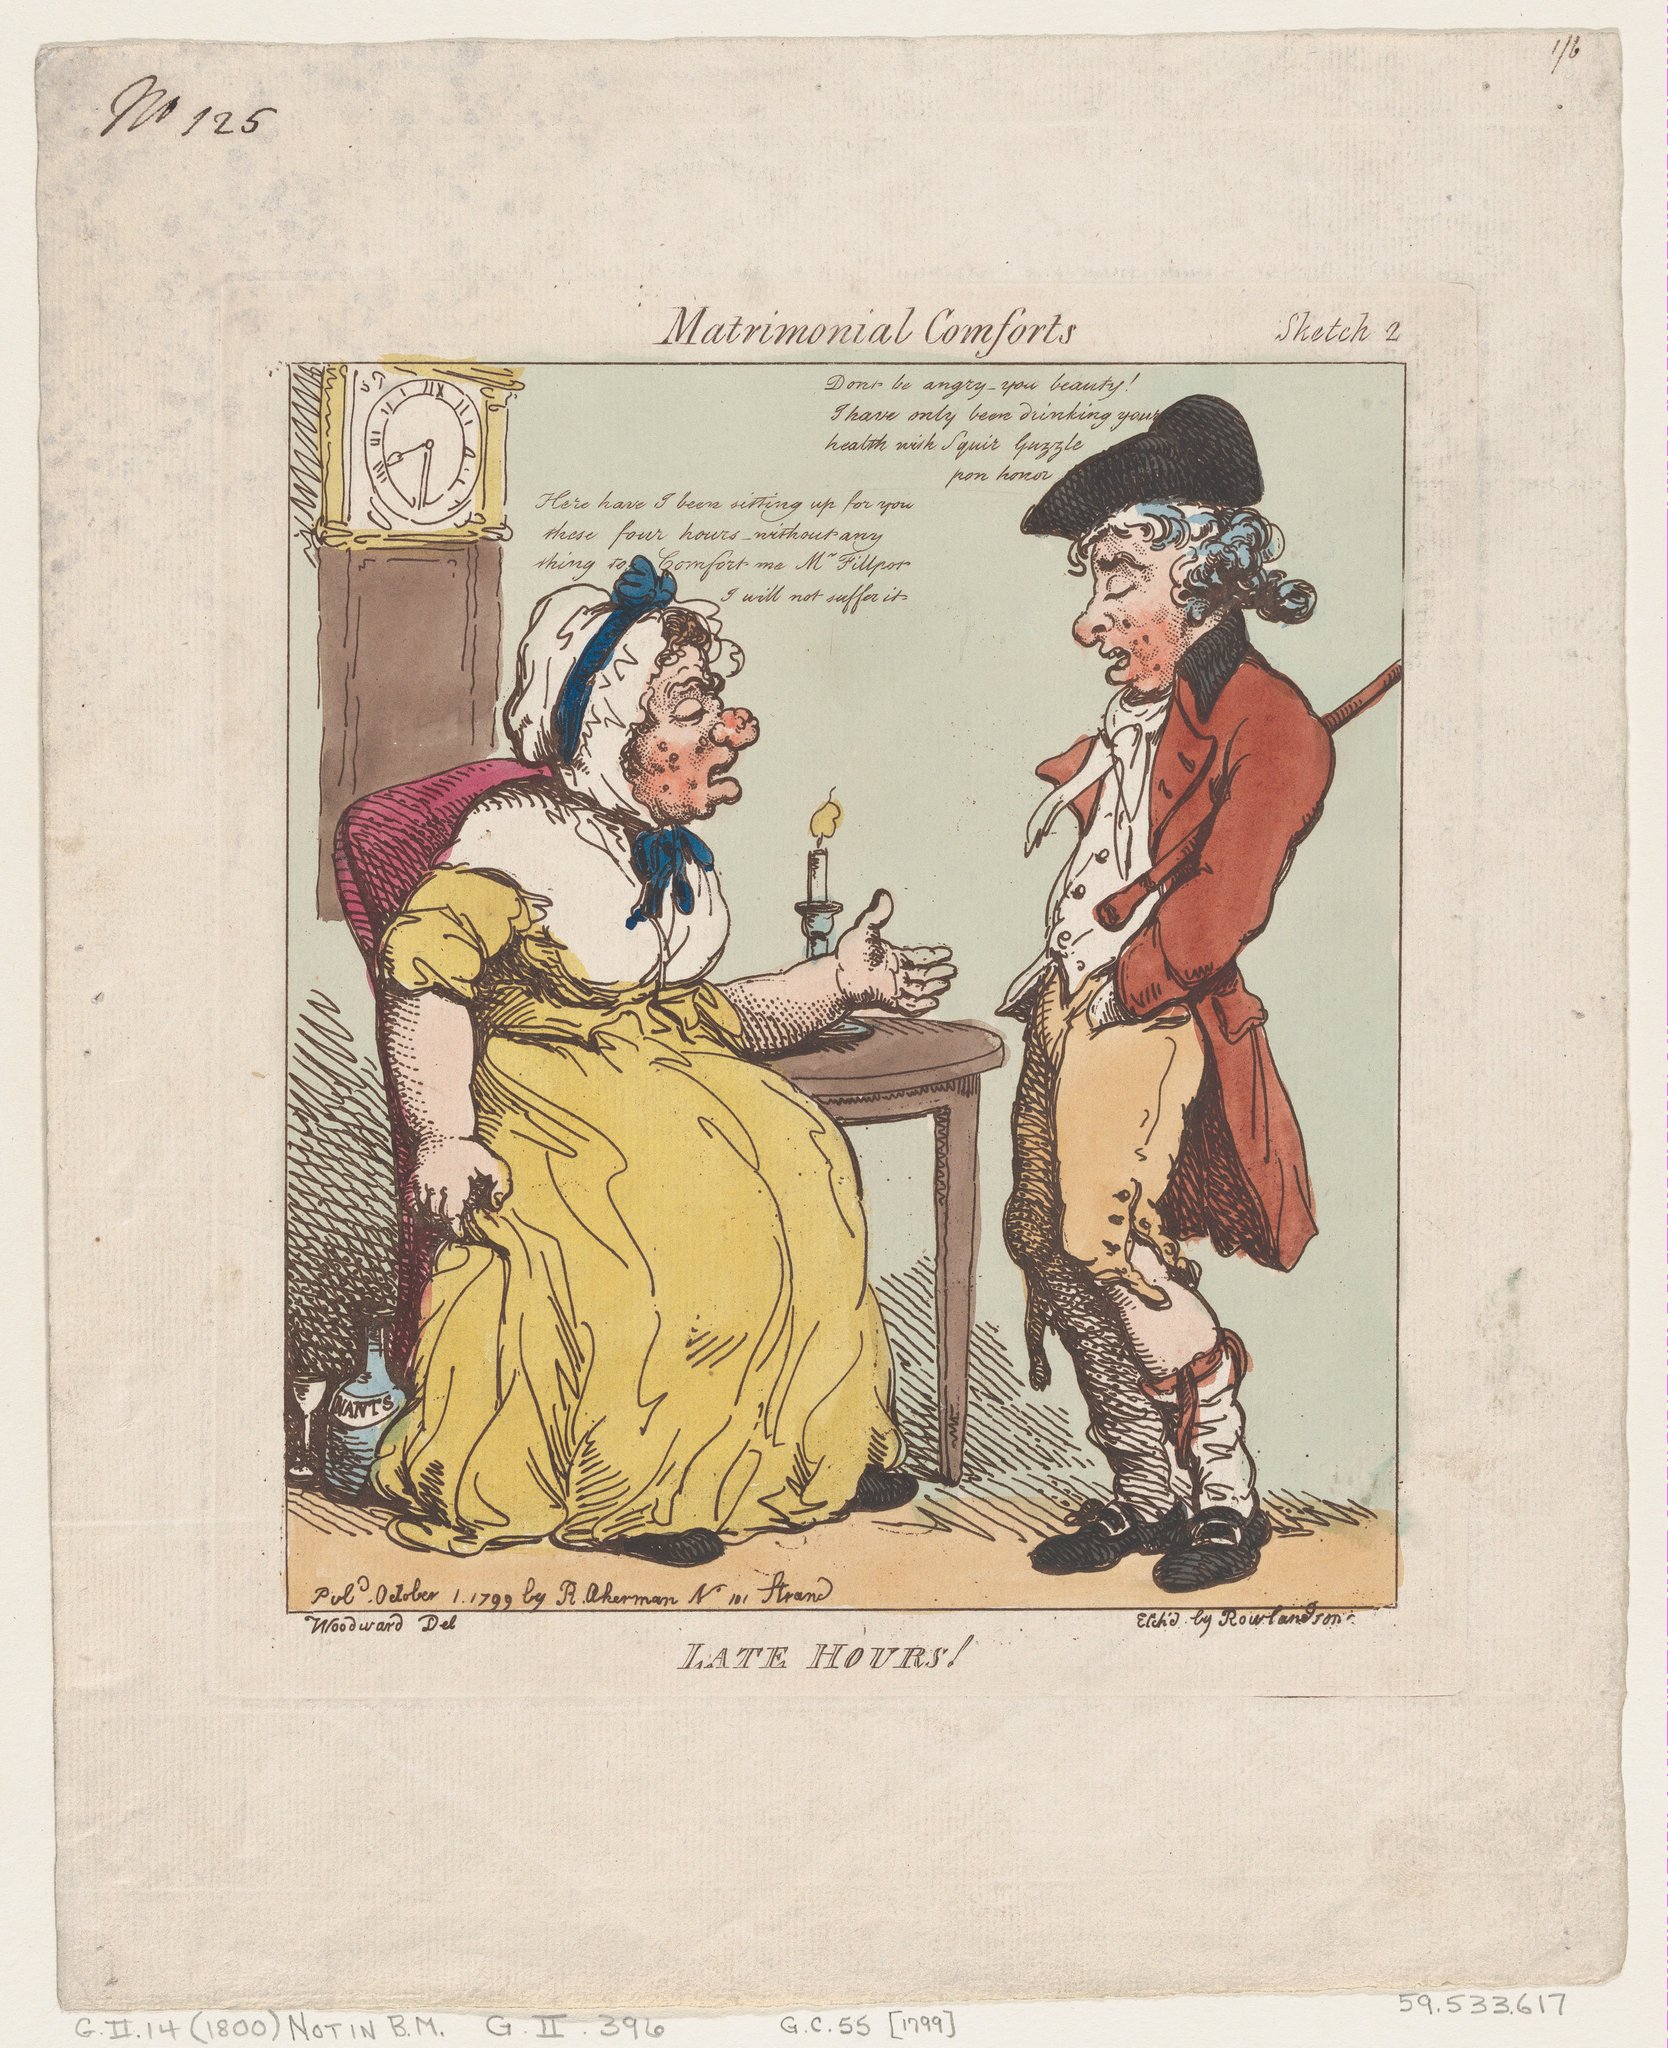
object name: print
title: Late Hours!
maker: thomas rowlandson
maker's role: artist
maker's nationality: british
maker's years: 1757-1827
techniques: etching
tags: satire,men,women,clocks